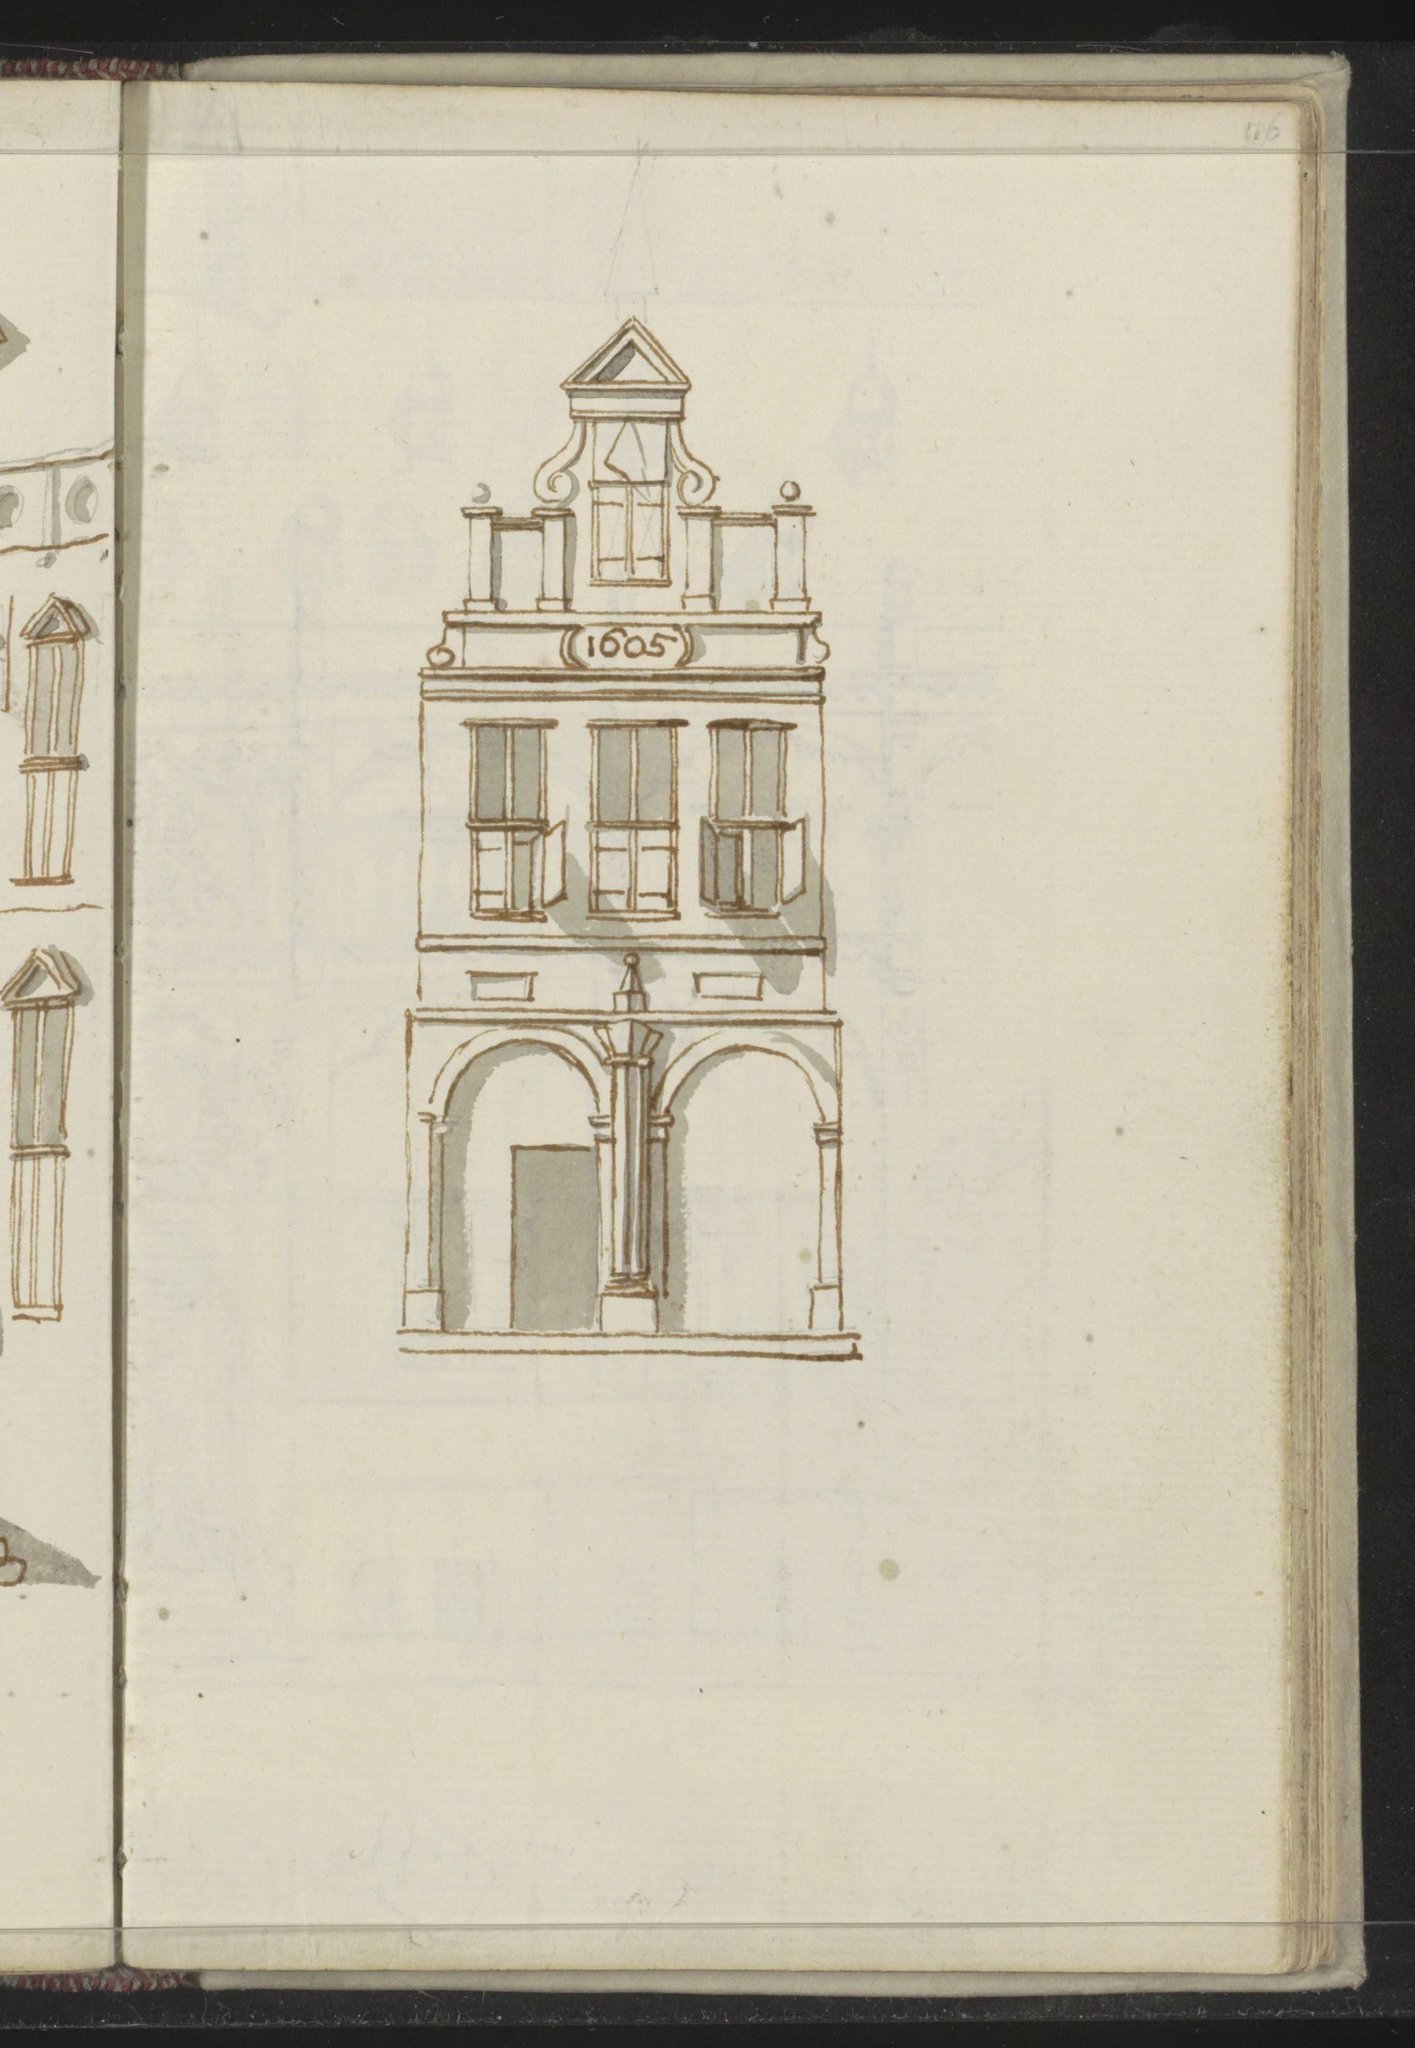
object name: sketchbook leaf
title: Geveltop met rolwerk, vermoedelijk te Nijmegen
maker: johannes huibert prins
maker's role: draughtsman, painter, print maker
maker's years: 1757-1806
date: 1783-1797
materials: ink, paper, pencil, watercolor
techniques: brush, pen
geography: nijmegen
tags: decorated gable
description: Pagina 116 uit een schetsboek met 175 pagina's.